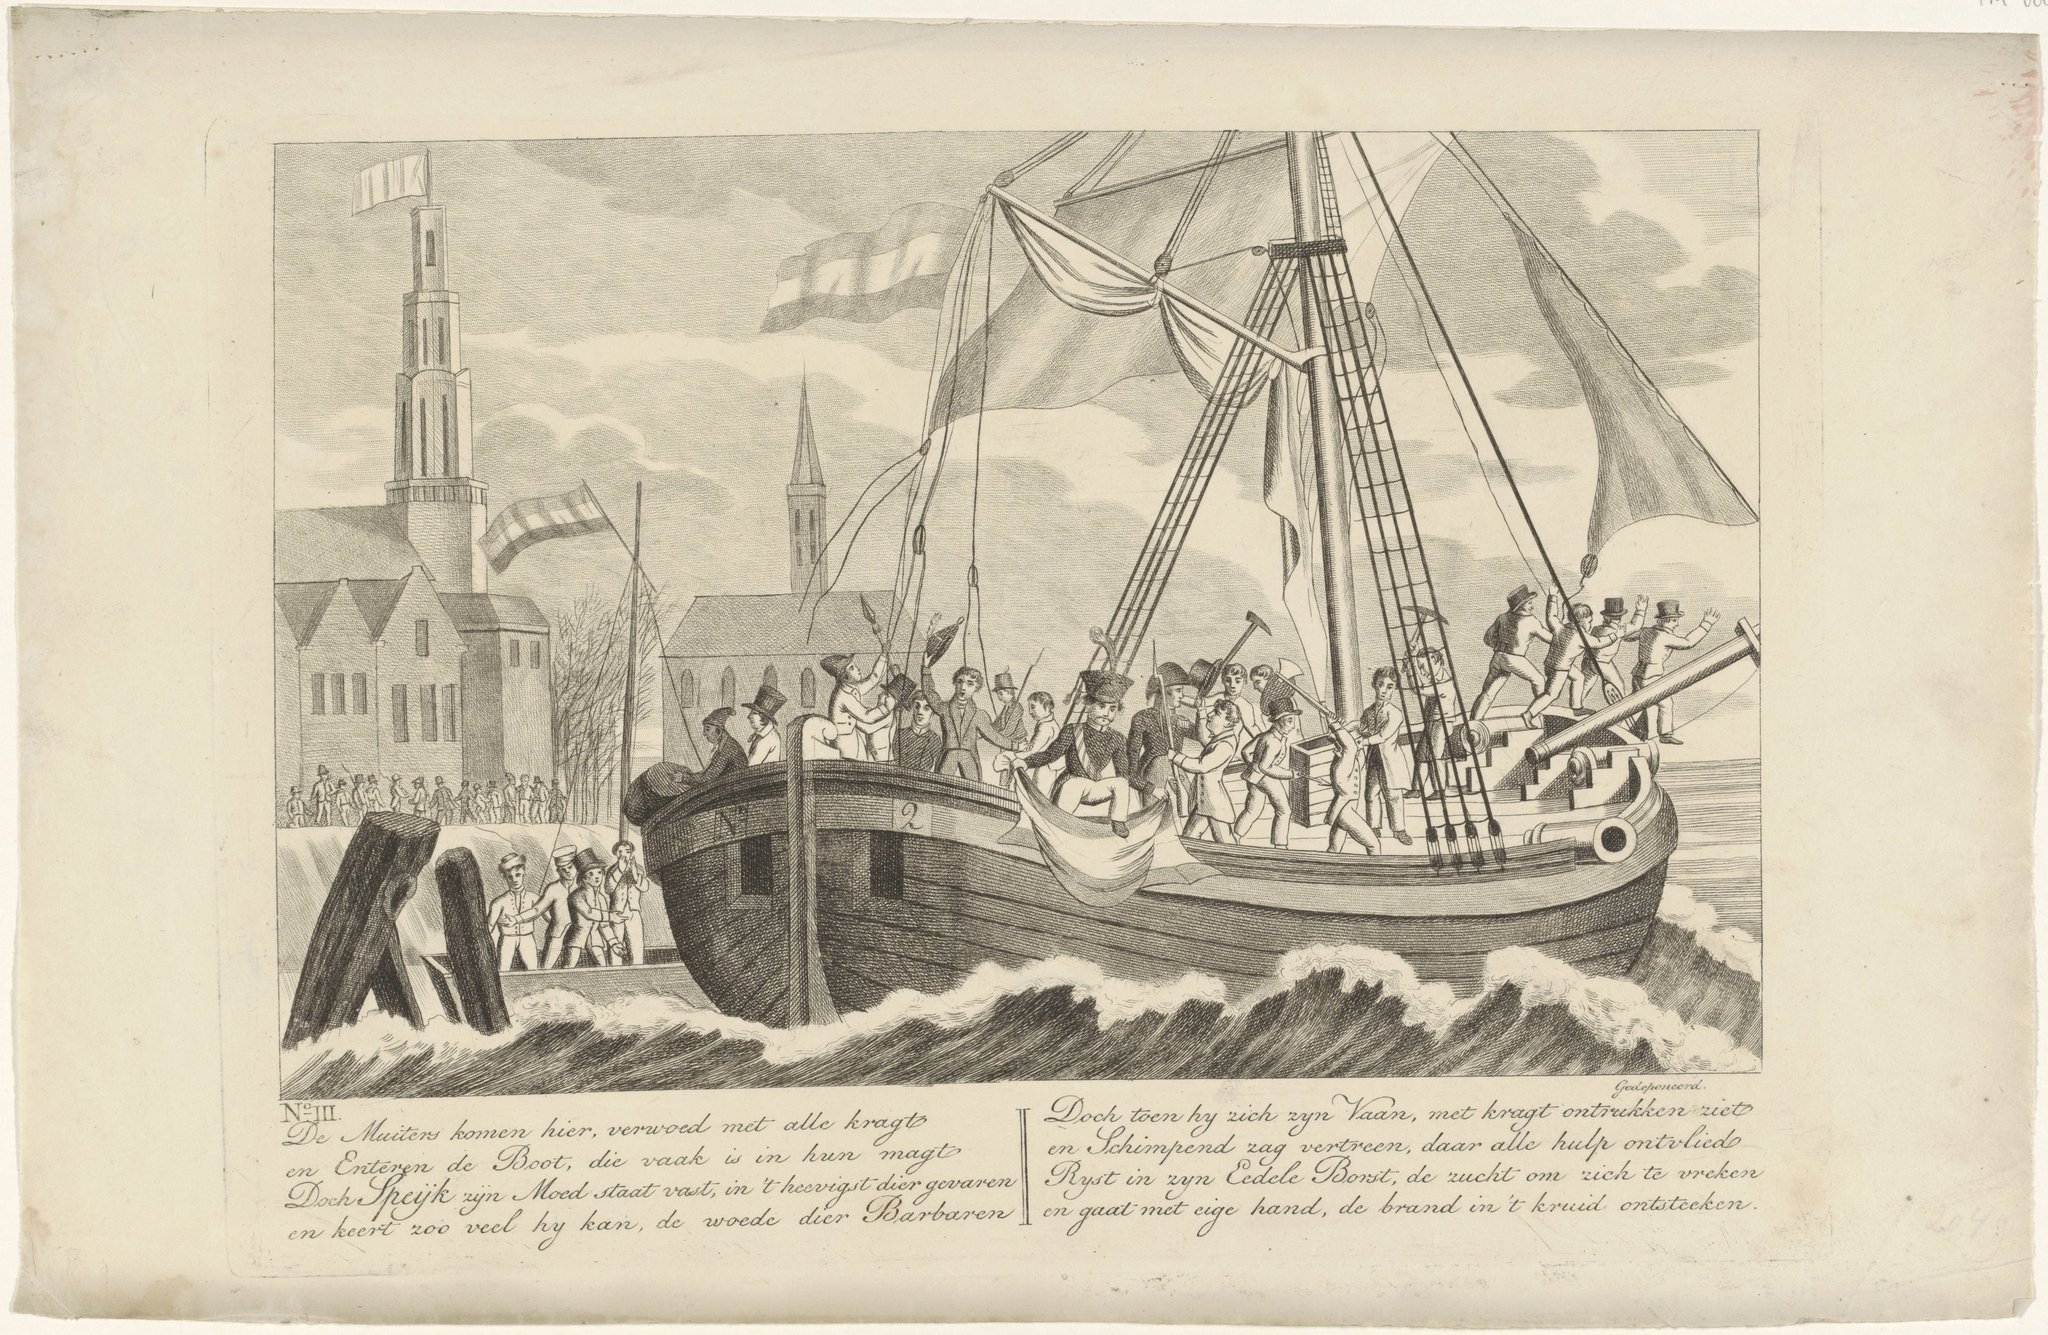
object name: print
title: Vier episoden uit de geschiedenis van Jan van Speyk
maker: Anonymous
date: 1831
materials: paper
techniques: engraving, etching, roulette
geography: netherlands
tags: amsterdam, antwerp, jan van speyk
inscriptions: collector's mark: Lugt 2228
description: De kanonneerboot van Jan van Speyk overmeesterd door de Belgen, 5 februari 1831. Een Belgische soldaat vertrapt de Nederlandse vlag, enkele matrozen springen overboord. Verschillende Belgen vallen met bijlen en houwelen het schip aan. Derde prent in een serie van vier platen van de geschiedenis van Jan van Speyk. Met twee vierregelige verzen in het onderschrift.